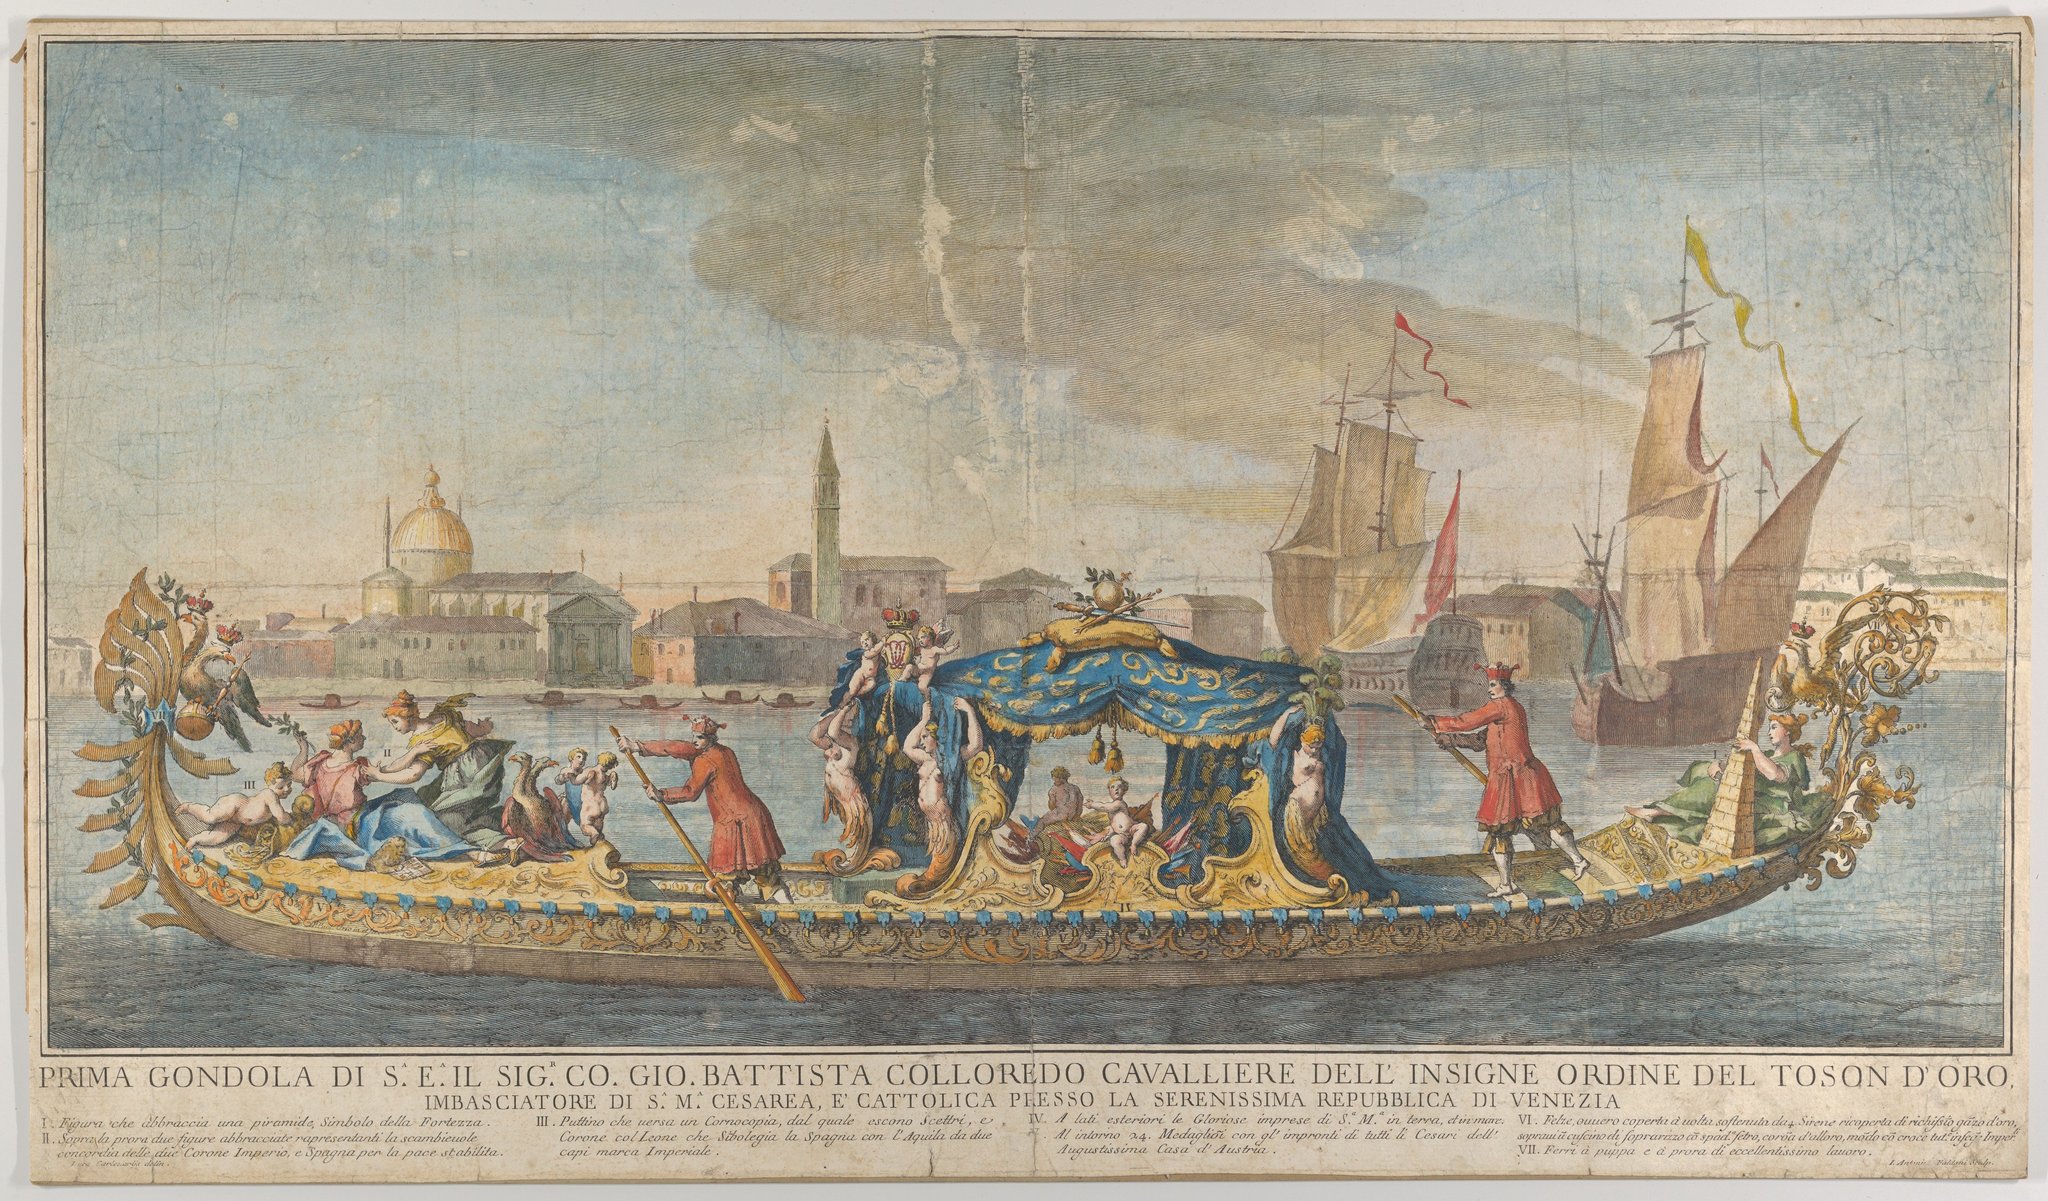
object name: print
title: The highly ornamented first gondola of Ambassador Giovanni Battista Colloreado entering Venice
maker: giovanni antonio faldoni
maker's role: artist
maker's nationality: italian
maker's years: 1690-1770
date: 1720-1730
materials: board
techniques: engraving, hand coloring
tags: ornament,men,women,canals,boats,venice